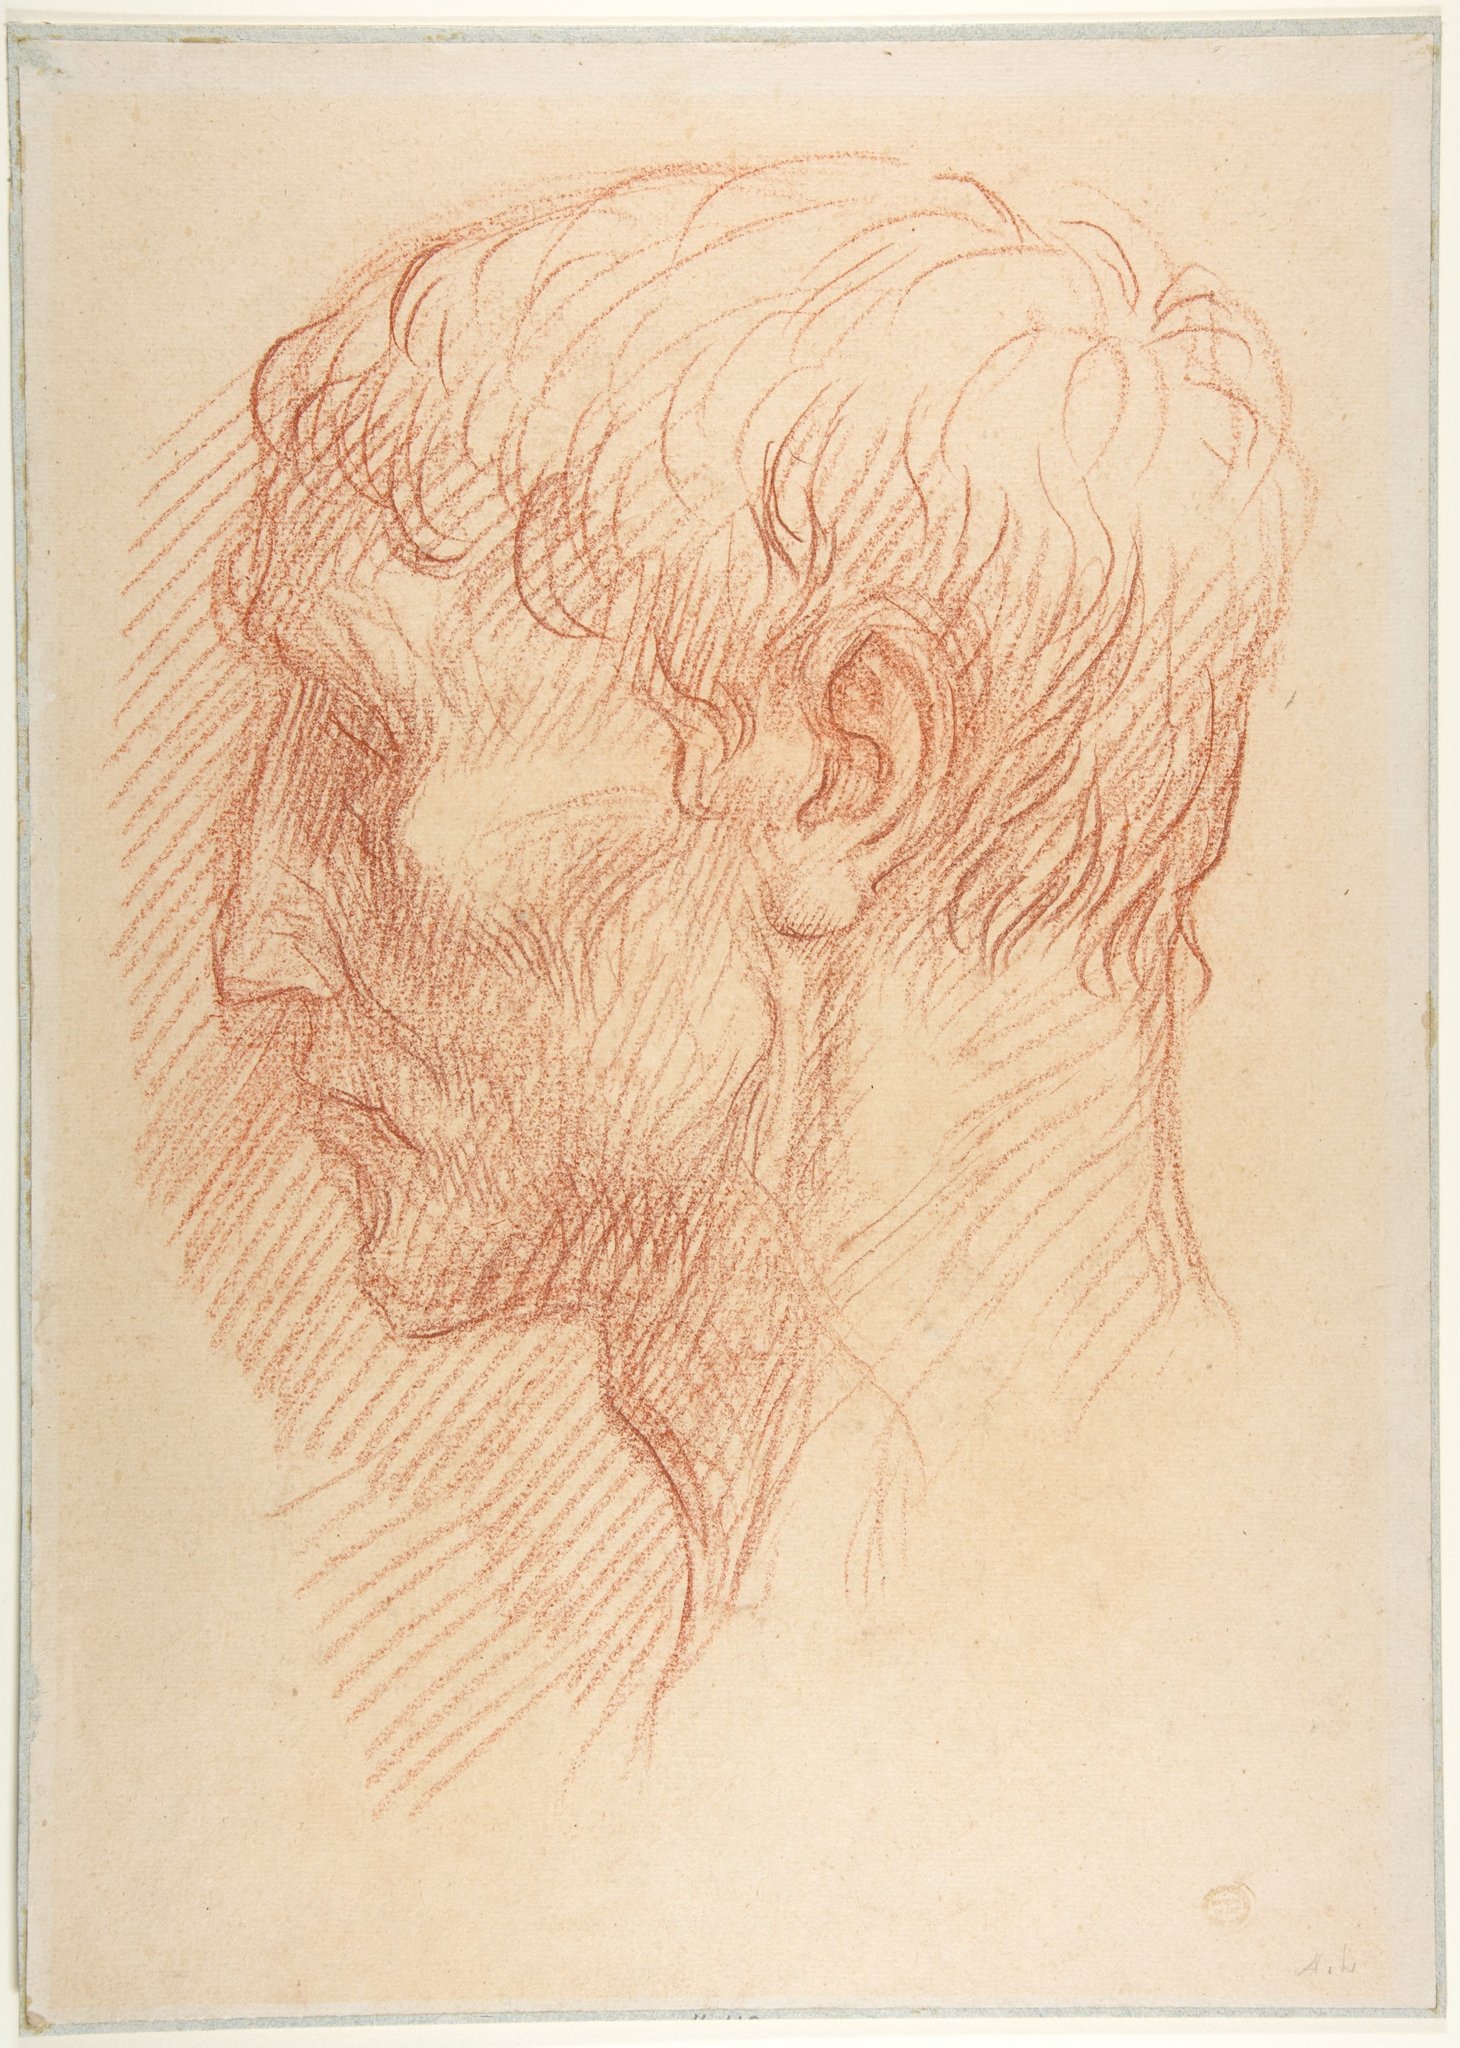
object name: drawing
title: Head of a Quarryman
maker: alphonse legros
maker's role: artist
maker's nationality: french and british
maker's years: 1837-1911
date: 1837-1911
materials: chalk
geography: france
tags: heads,men